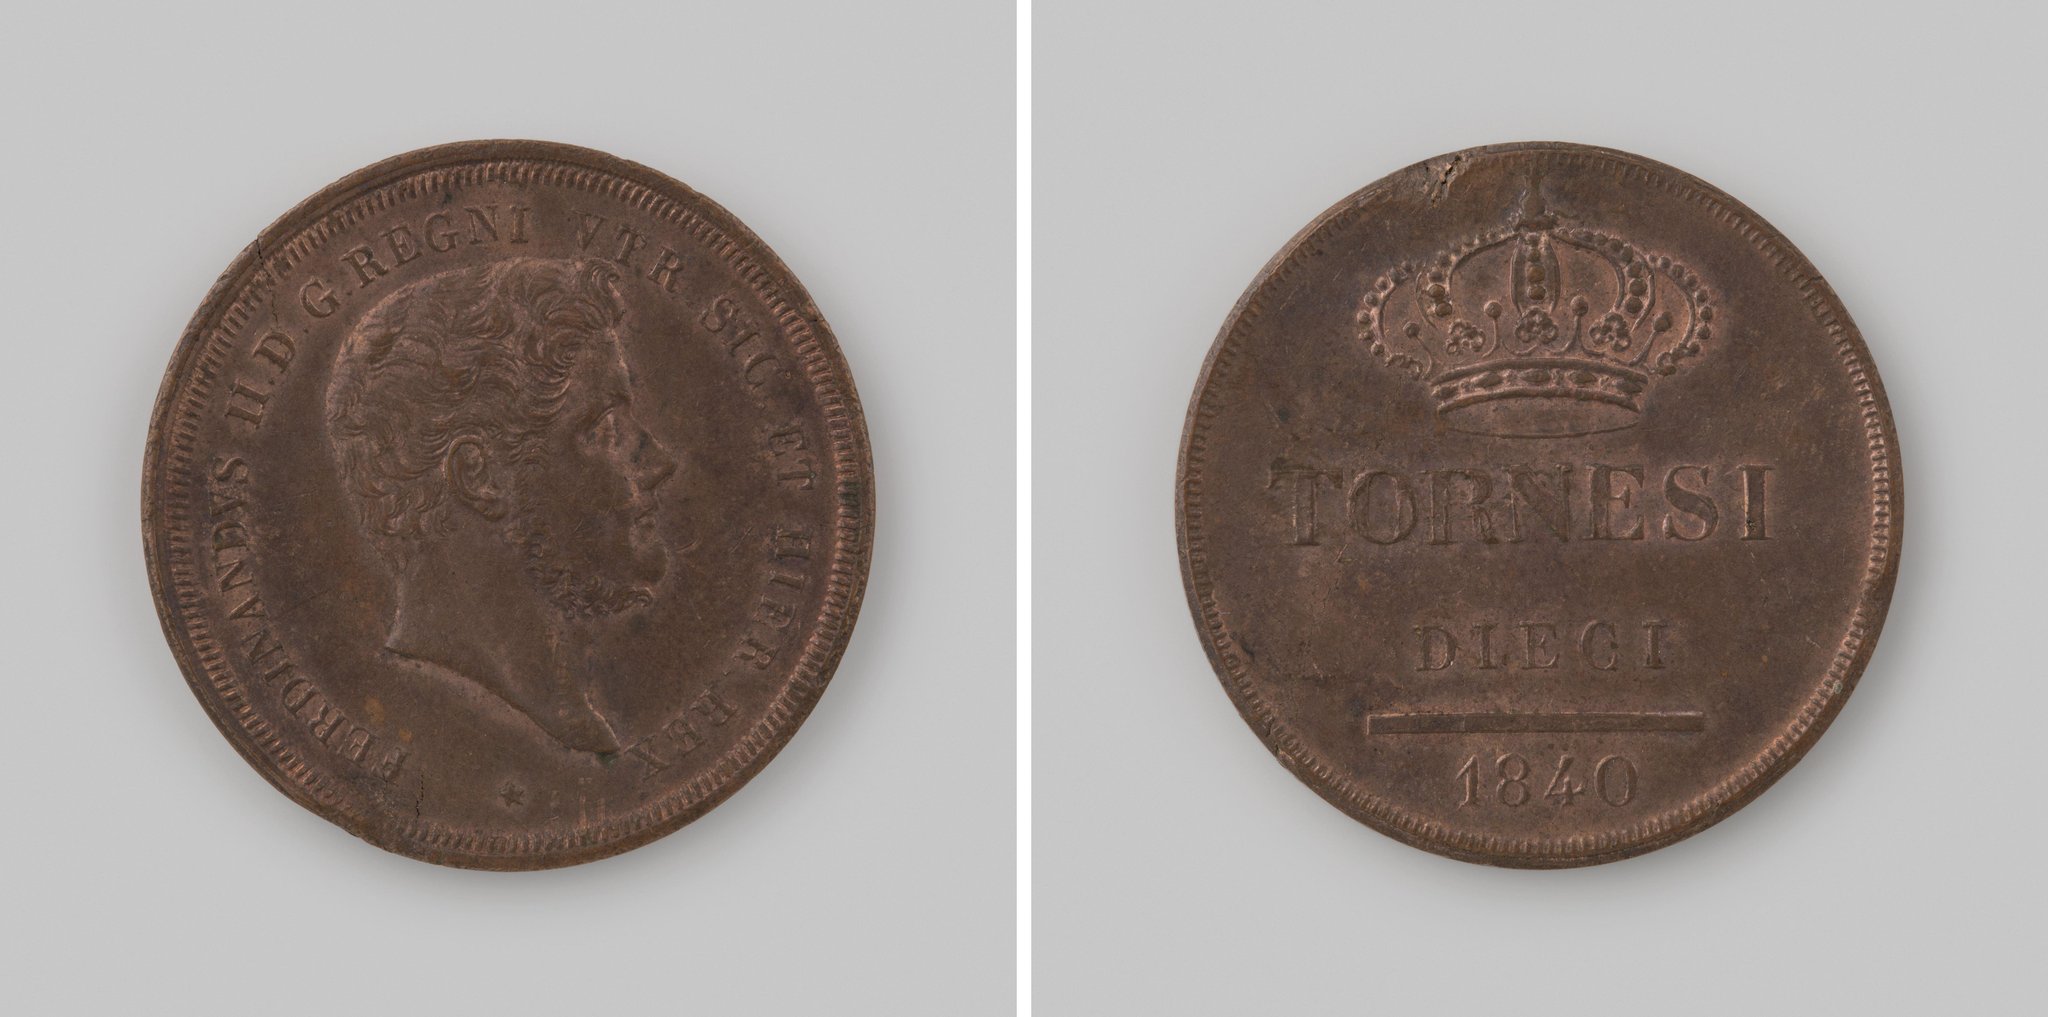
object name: coin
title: 10 tornesi uit het koninkrijk Napels van de beide Siciliën van Ferdinando II, 1840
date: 1840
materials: copper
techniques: striking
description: Koperen munt. Voorzijde: hoofd naar rechts. Keerzijde: kroon, waaronder in twee regels waarde-aanduiding. Jaartal in afsnede onderaan. Kartelrand.